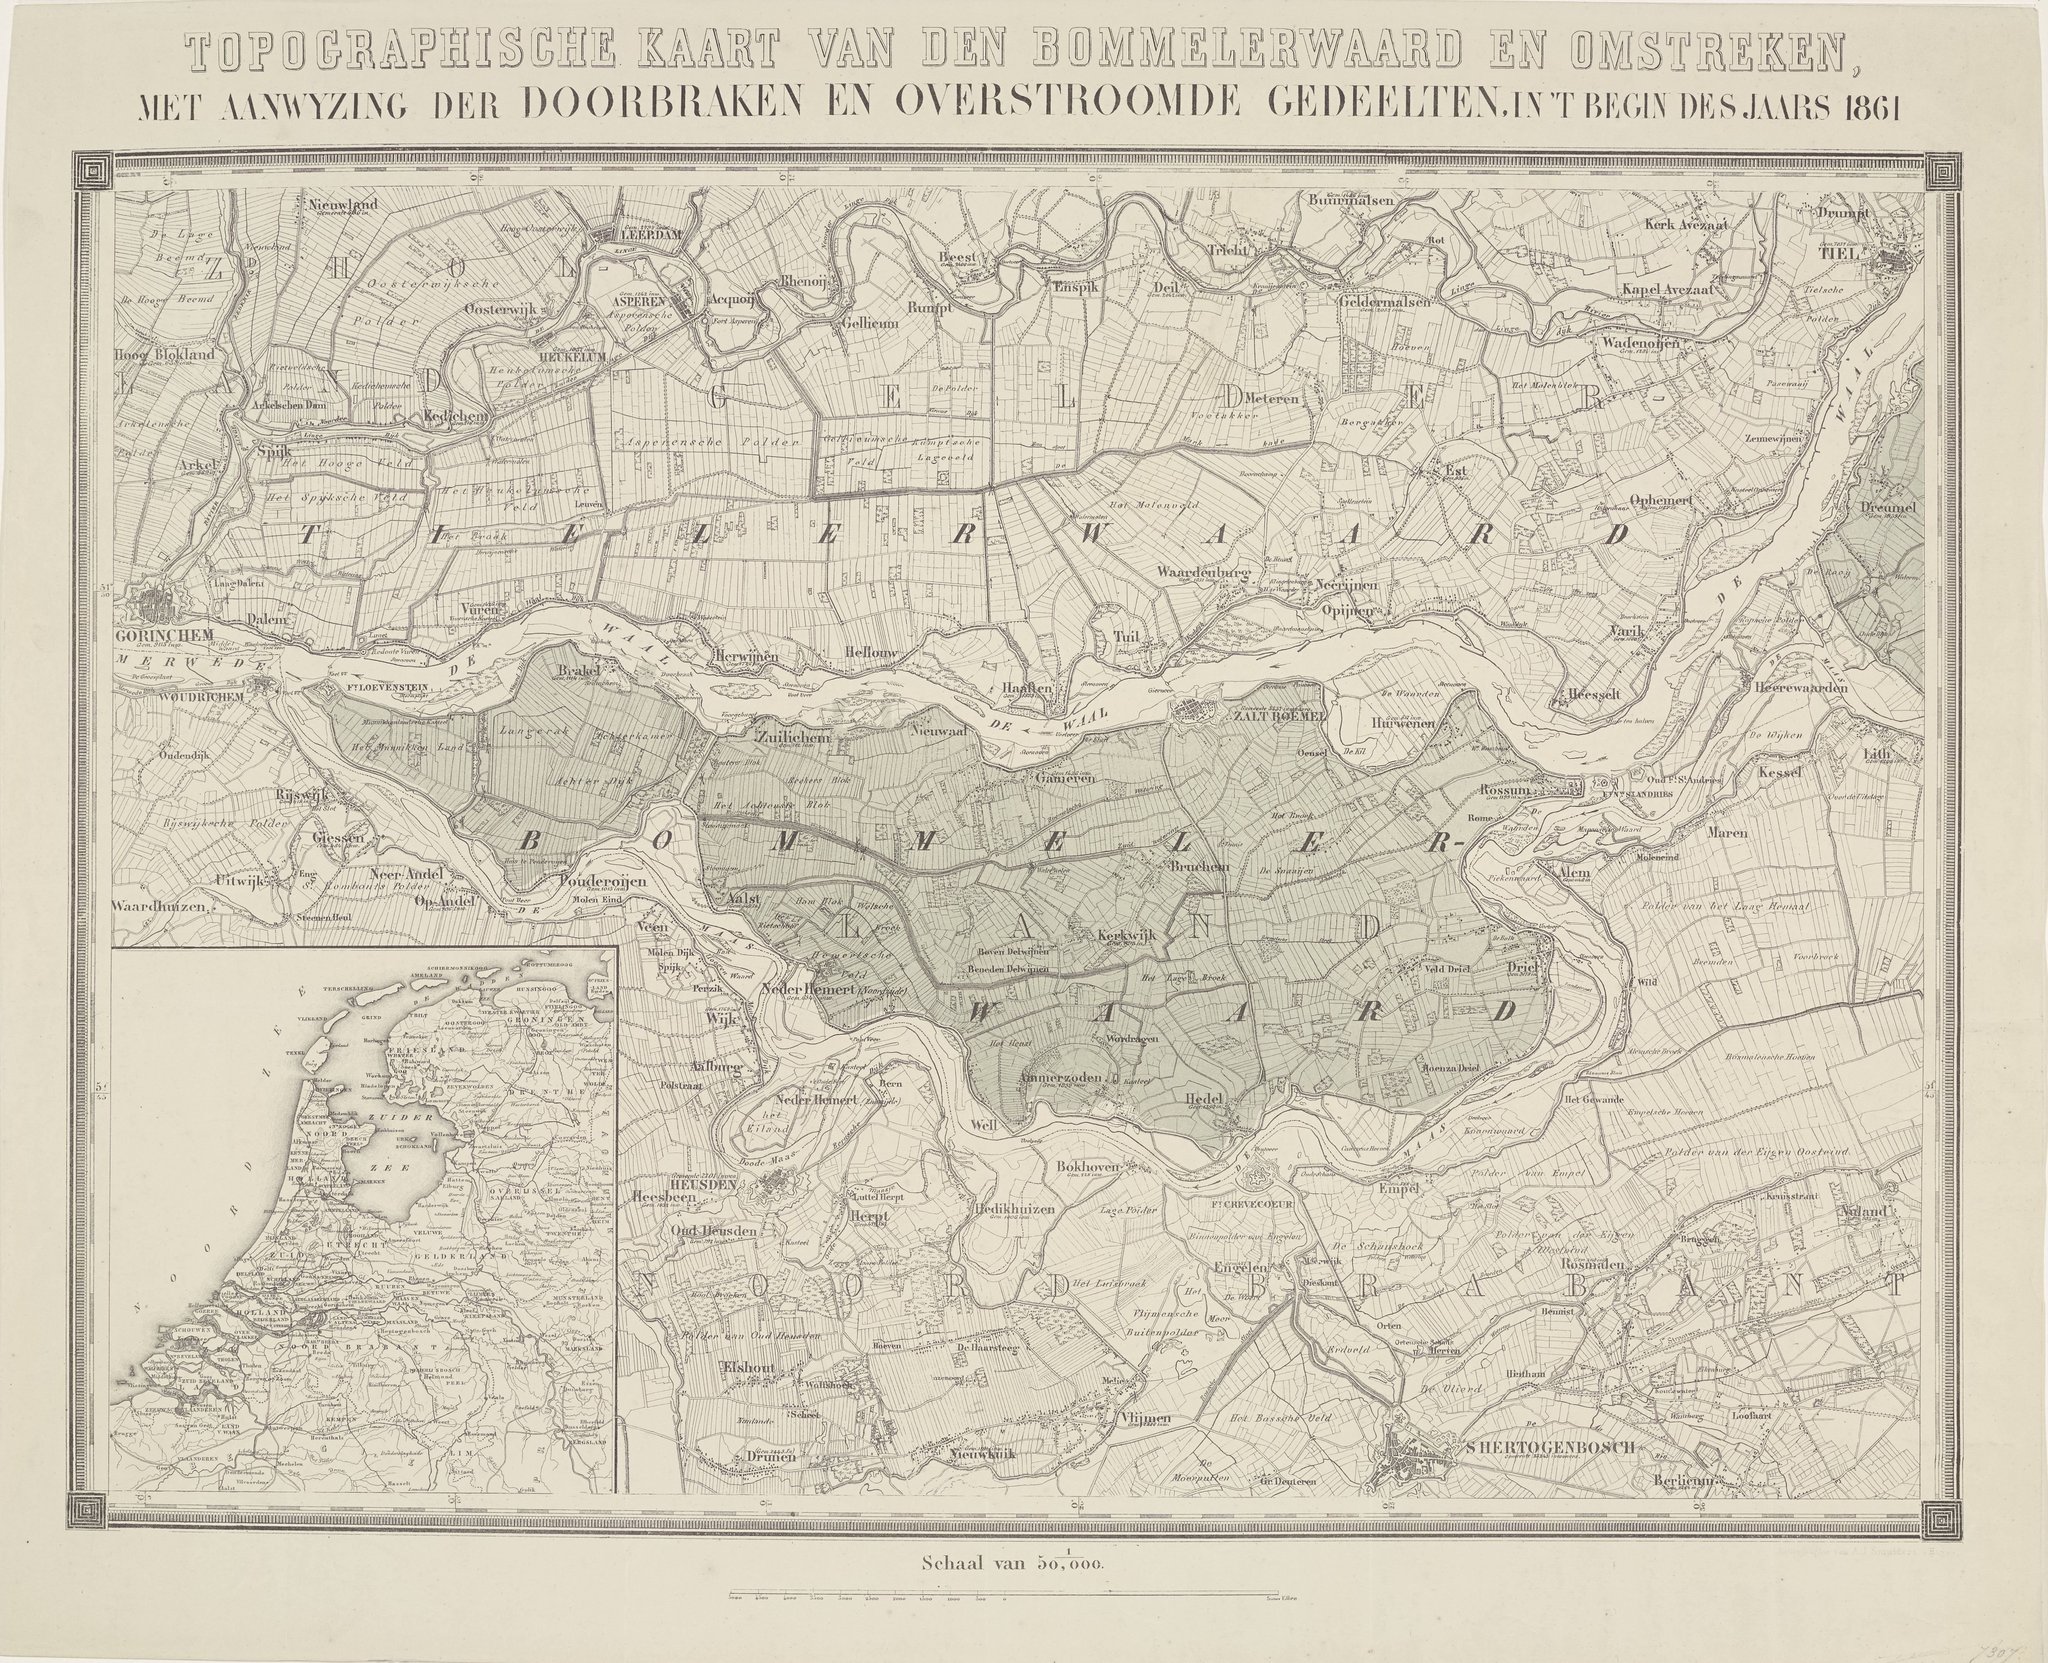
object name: print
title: Topographische kaart van den Bommelerwaard en omstreken, met aanwyzing der doorbraken en overstroomde gedeelten, in't begin der 1861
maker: a.j. smulders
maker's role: printer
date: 1861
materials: paper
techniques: lithograph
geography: the hague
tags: dike-break, maps of separate countries or regions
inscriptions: collector's mark: Lugt 2228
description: Kaart van de Bommelerwaard emn omstreken waarop is aan gegeven het gebied getroffen door de watersnood van januari en februari 1861. Linksonder een inzet met een kaart van Nederland.